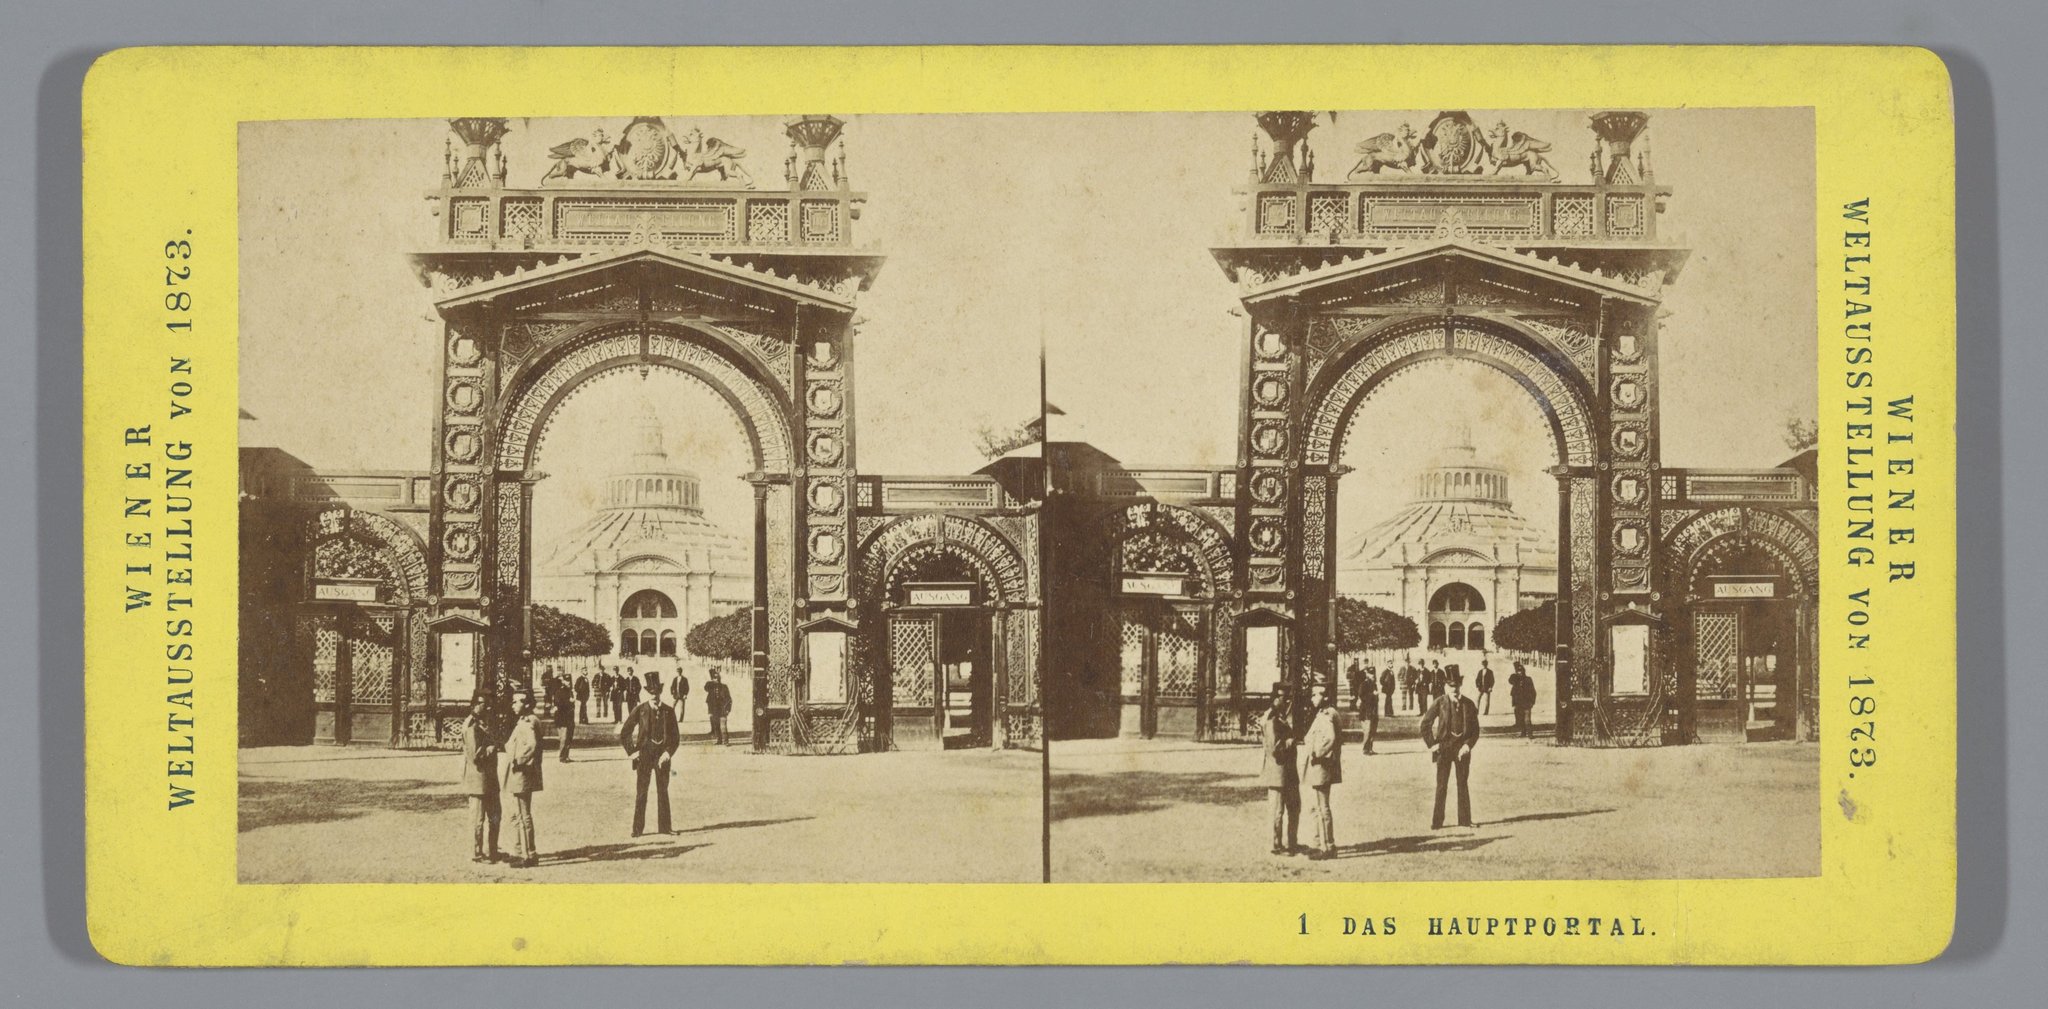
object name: stereograph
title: Toegangspoort met daarachter de Rotunde op de Wereldtentoonstelling van 1873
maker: Anonymous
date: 1873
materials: cardboard, paper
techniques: albumen print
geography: vienna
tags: world fair, world exhibition, arch, archivolt ~ architecture, gate, entrance, vienna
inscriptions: number: ‘1’, retailer's mark: ‘H.J. HUNCK,/ Prinsengracht 636,/ AMSTERDAM,’, inscription: ‘Tentoonstelling te Wenen 1873’